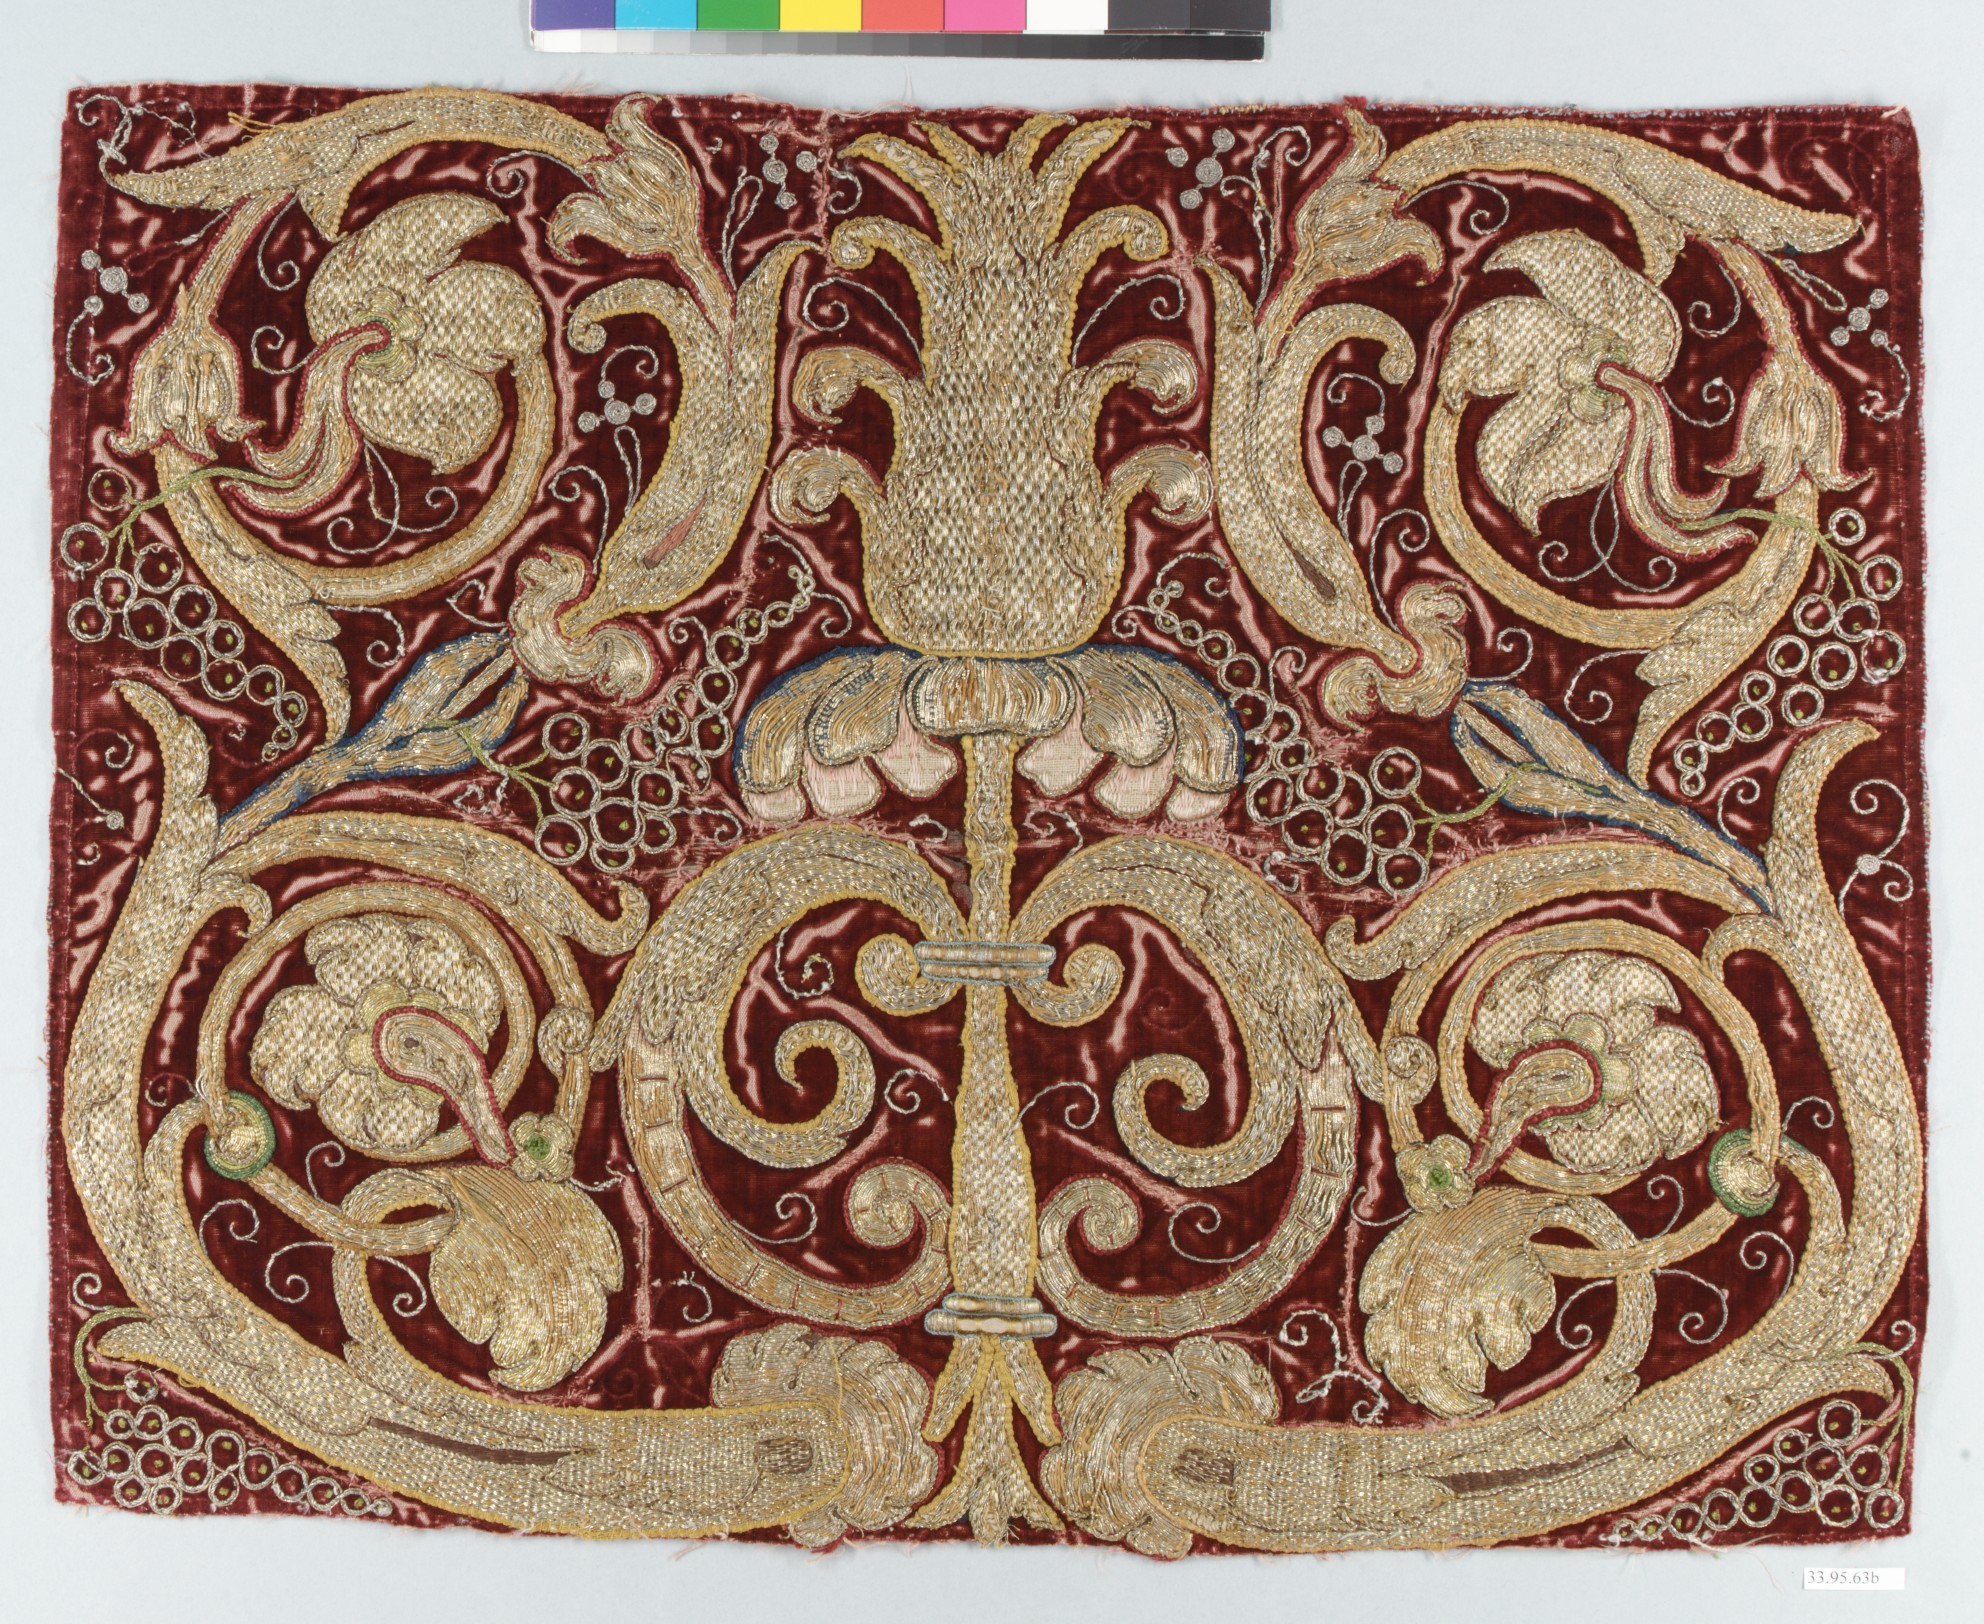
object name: clothing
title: Golden tendrils against a red ground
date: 1501-1600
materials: metal thread, silk, velvet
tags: flowers